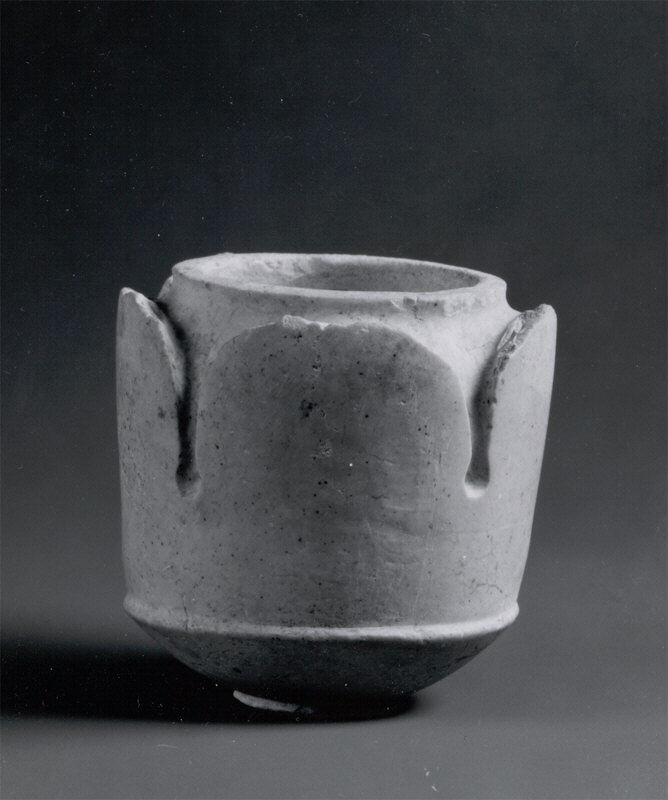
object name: container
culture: bactria-margiana archaeological complex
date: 2333-1668 BCE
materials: marble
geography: bactria-margiana